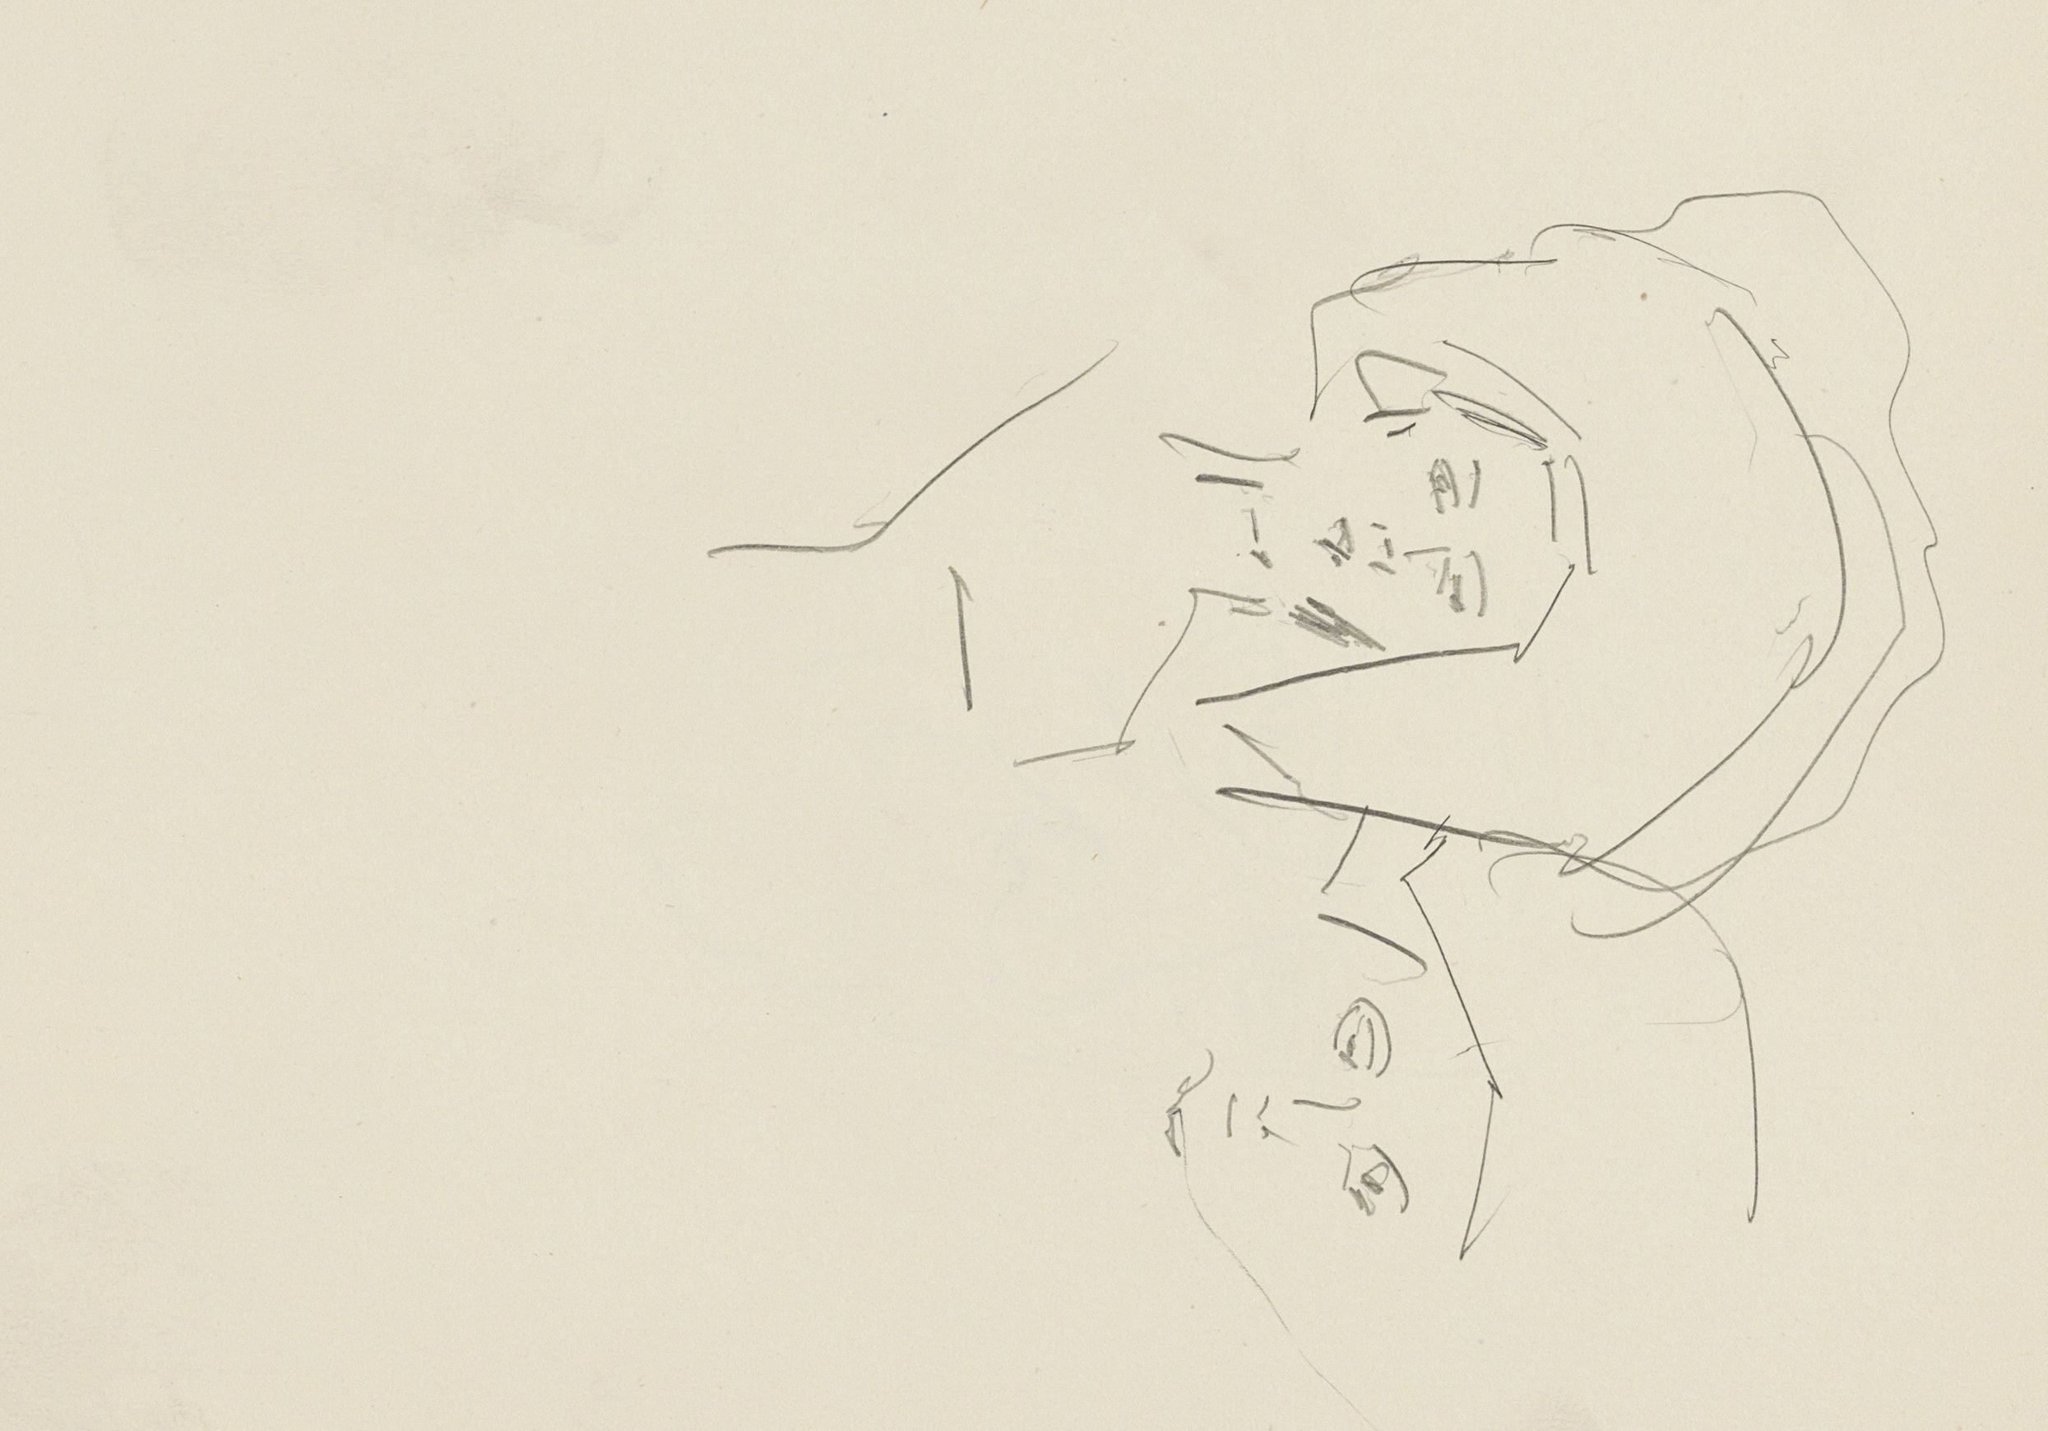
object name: sketchbook leaf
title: Twee vrouwenhoofden met hoeden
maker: isaac israels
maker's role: draughtsman, painter, print maker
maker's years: 1865-1934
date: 1915-1934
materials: paper, pencil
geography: the hague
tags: head-gear: hat (+ women's clothes), head (human) - aa - female human figure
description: Blad 16 recto uit schetsboek XXV met 23 bladen.